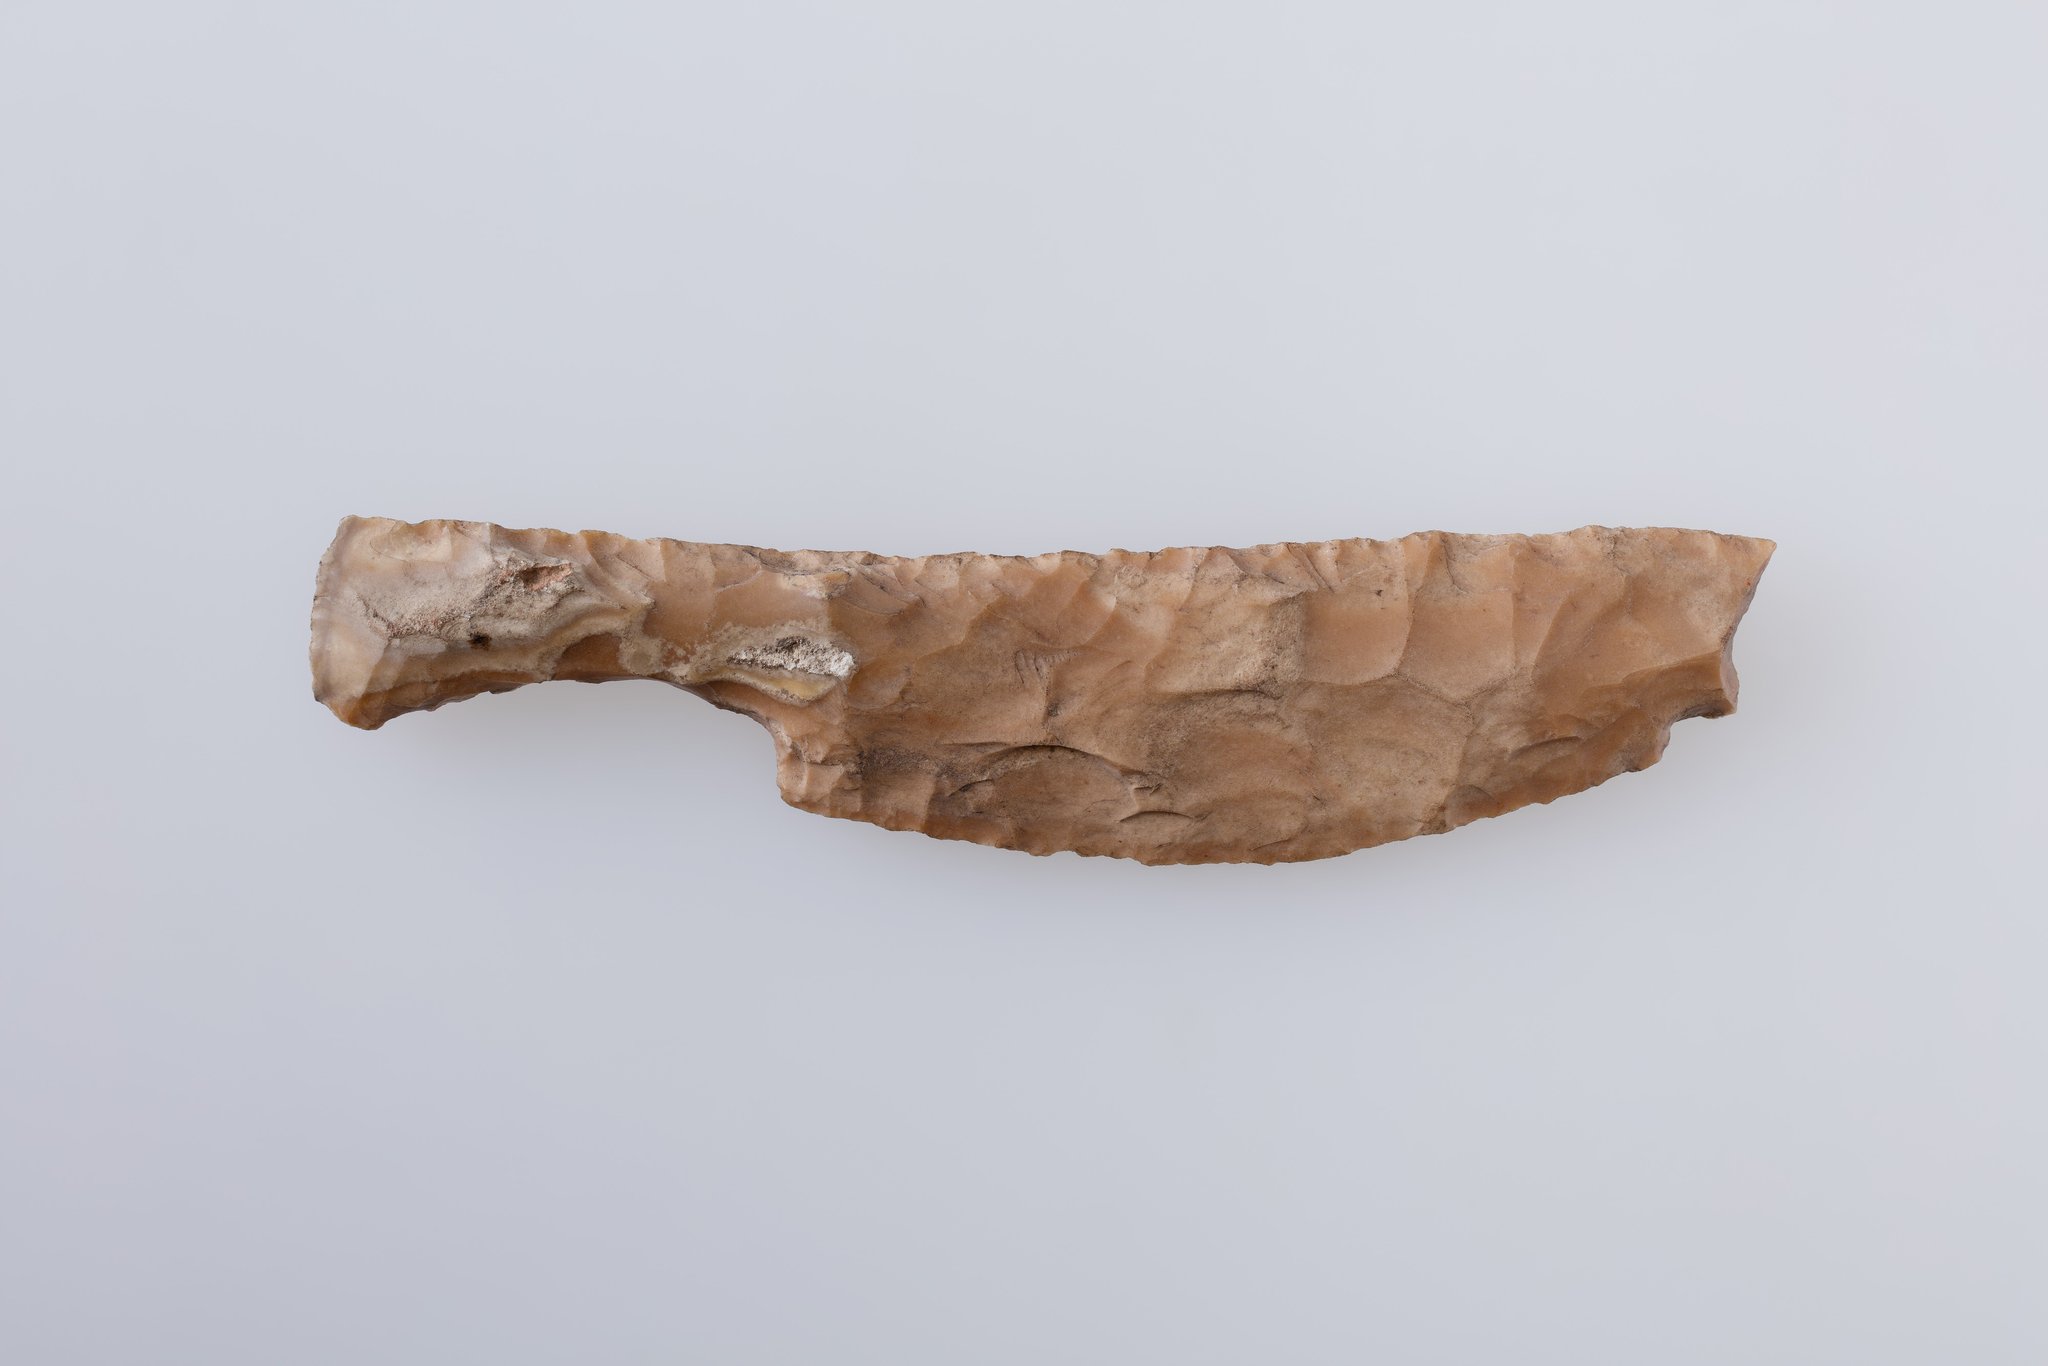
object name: knife, bifacial knife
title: Bifacial knife with handle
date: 3100-2649 BCE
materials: stone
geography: egypt